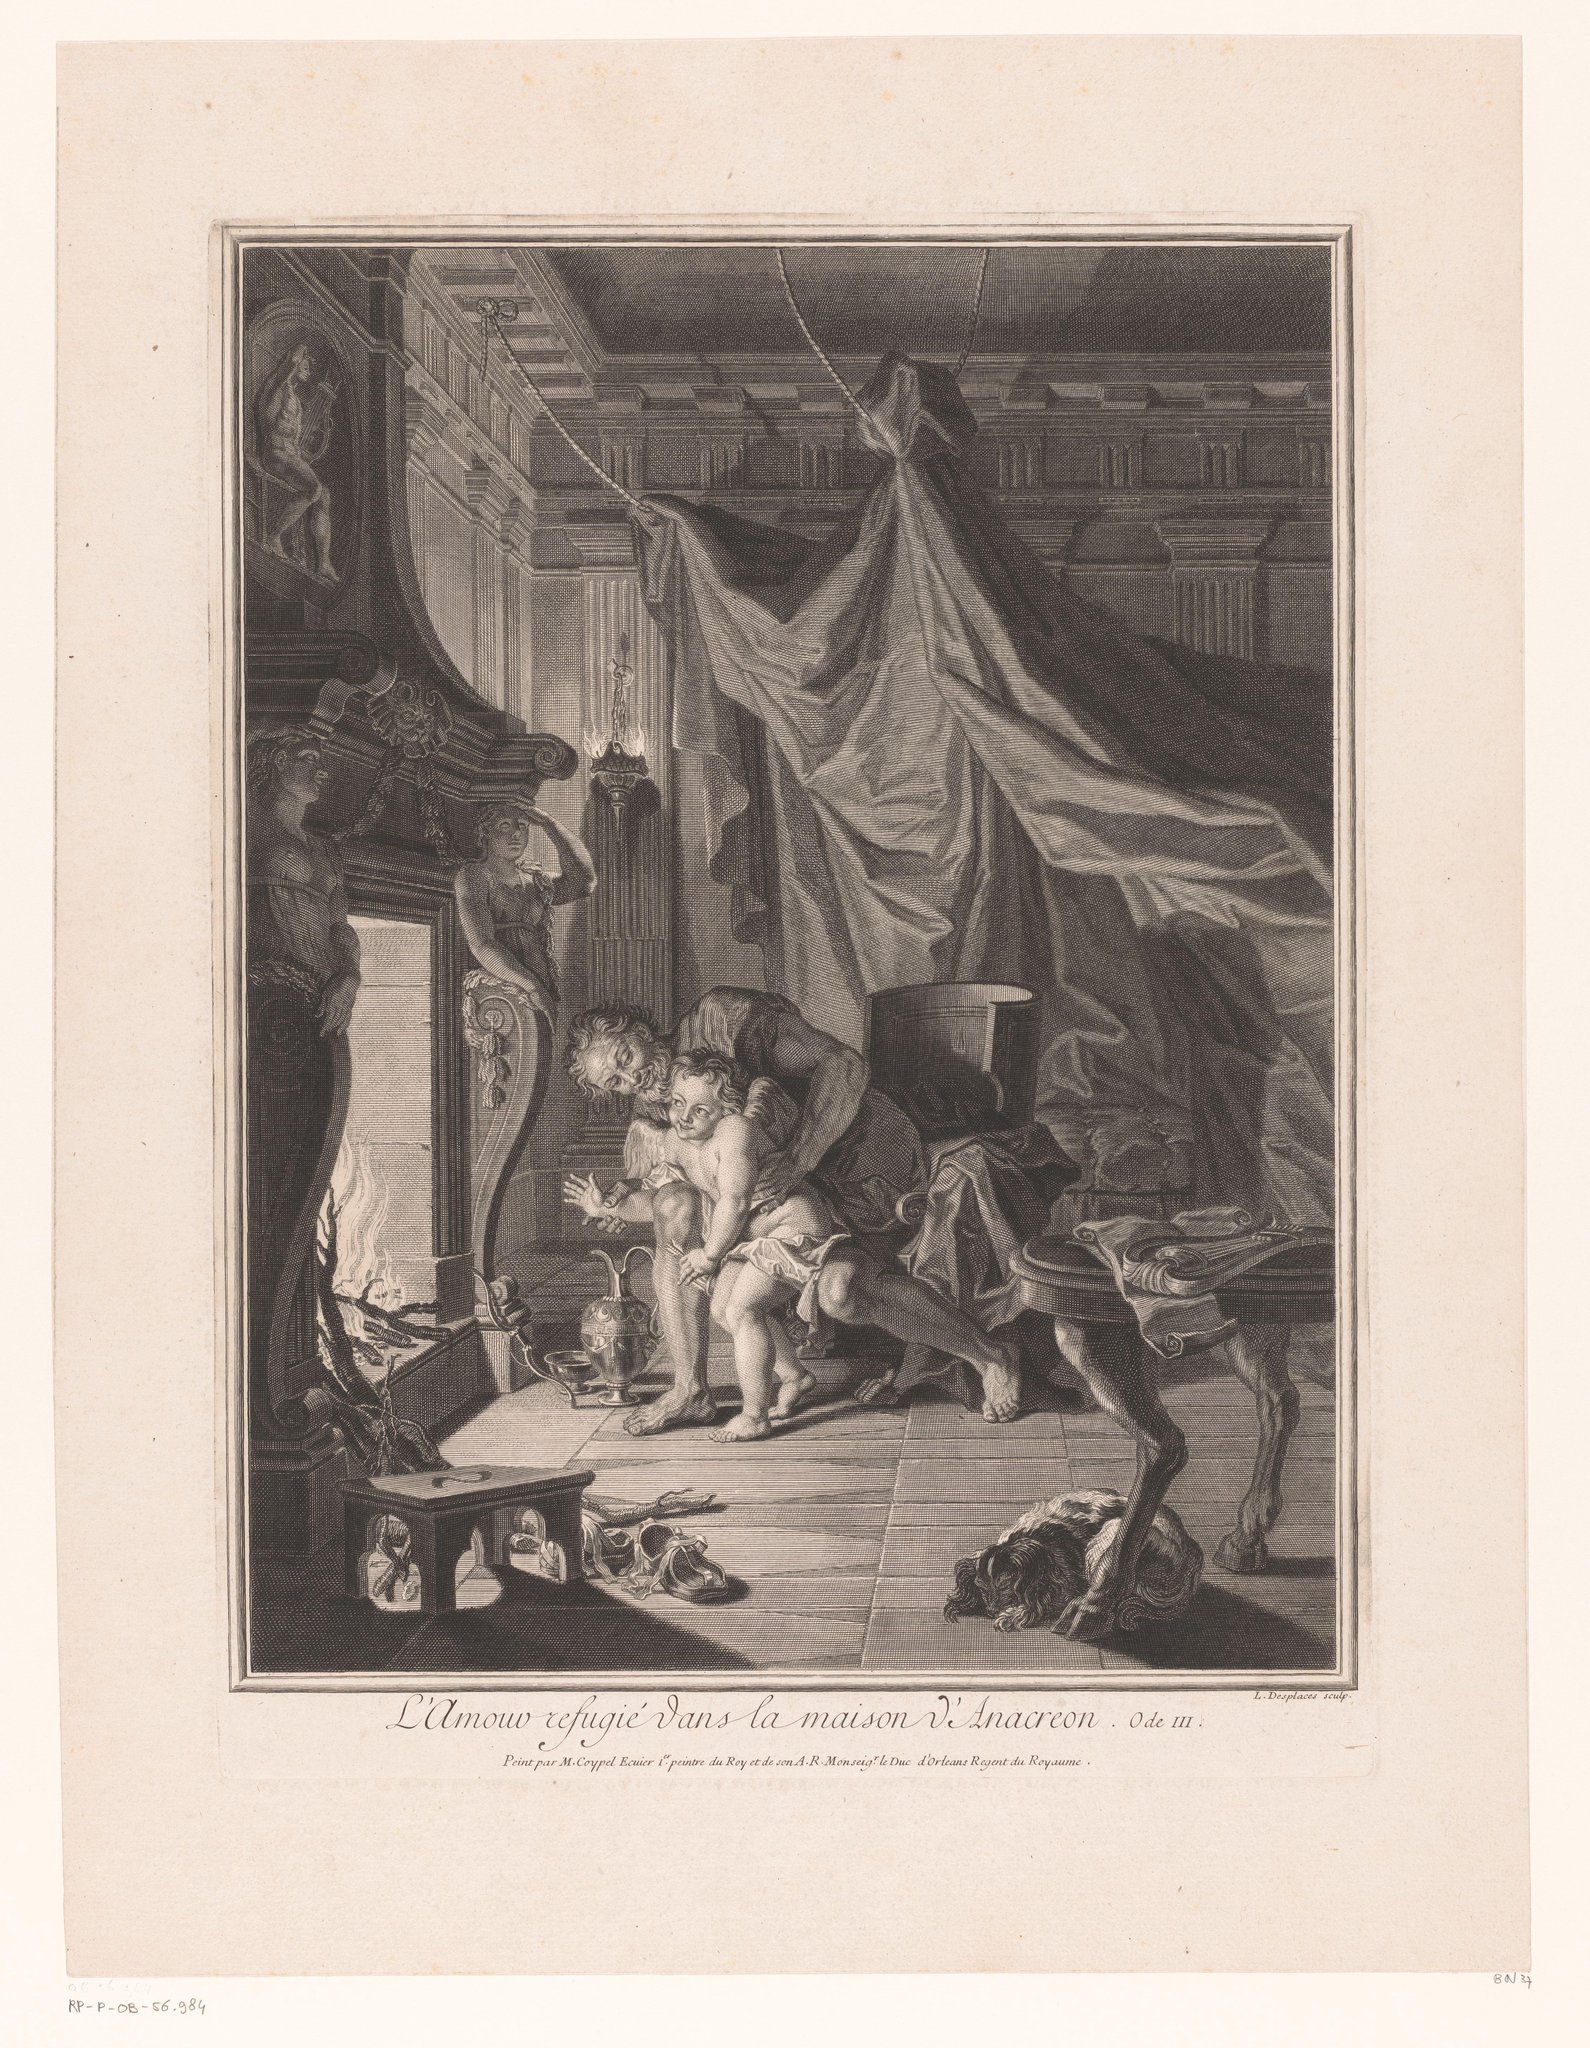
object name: print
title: L'Amour réfugié dans la maison d'Anacréon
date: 1692-1739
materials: paper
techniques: engraving, etching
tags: (story of) anacreon, (story of) cupid, amor (eros)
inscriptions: collector's mark: Lugt 240